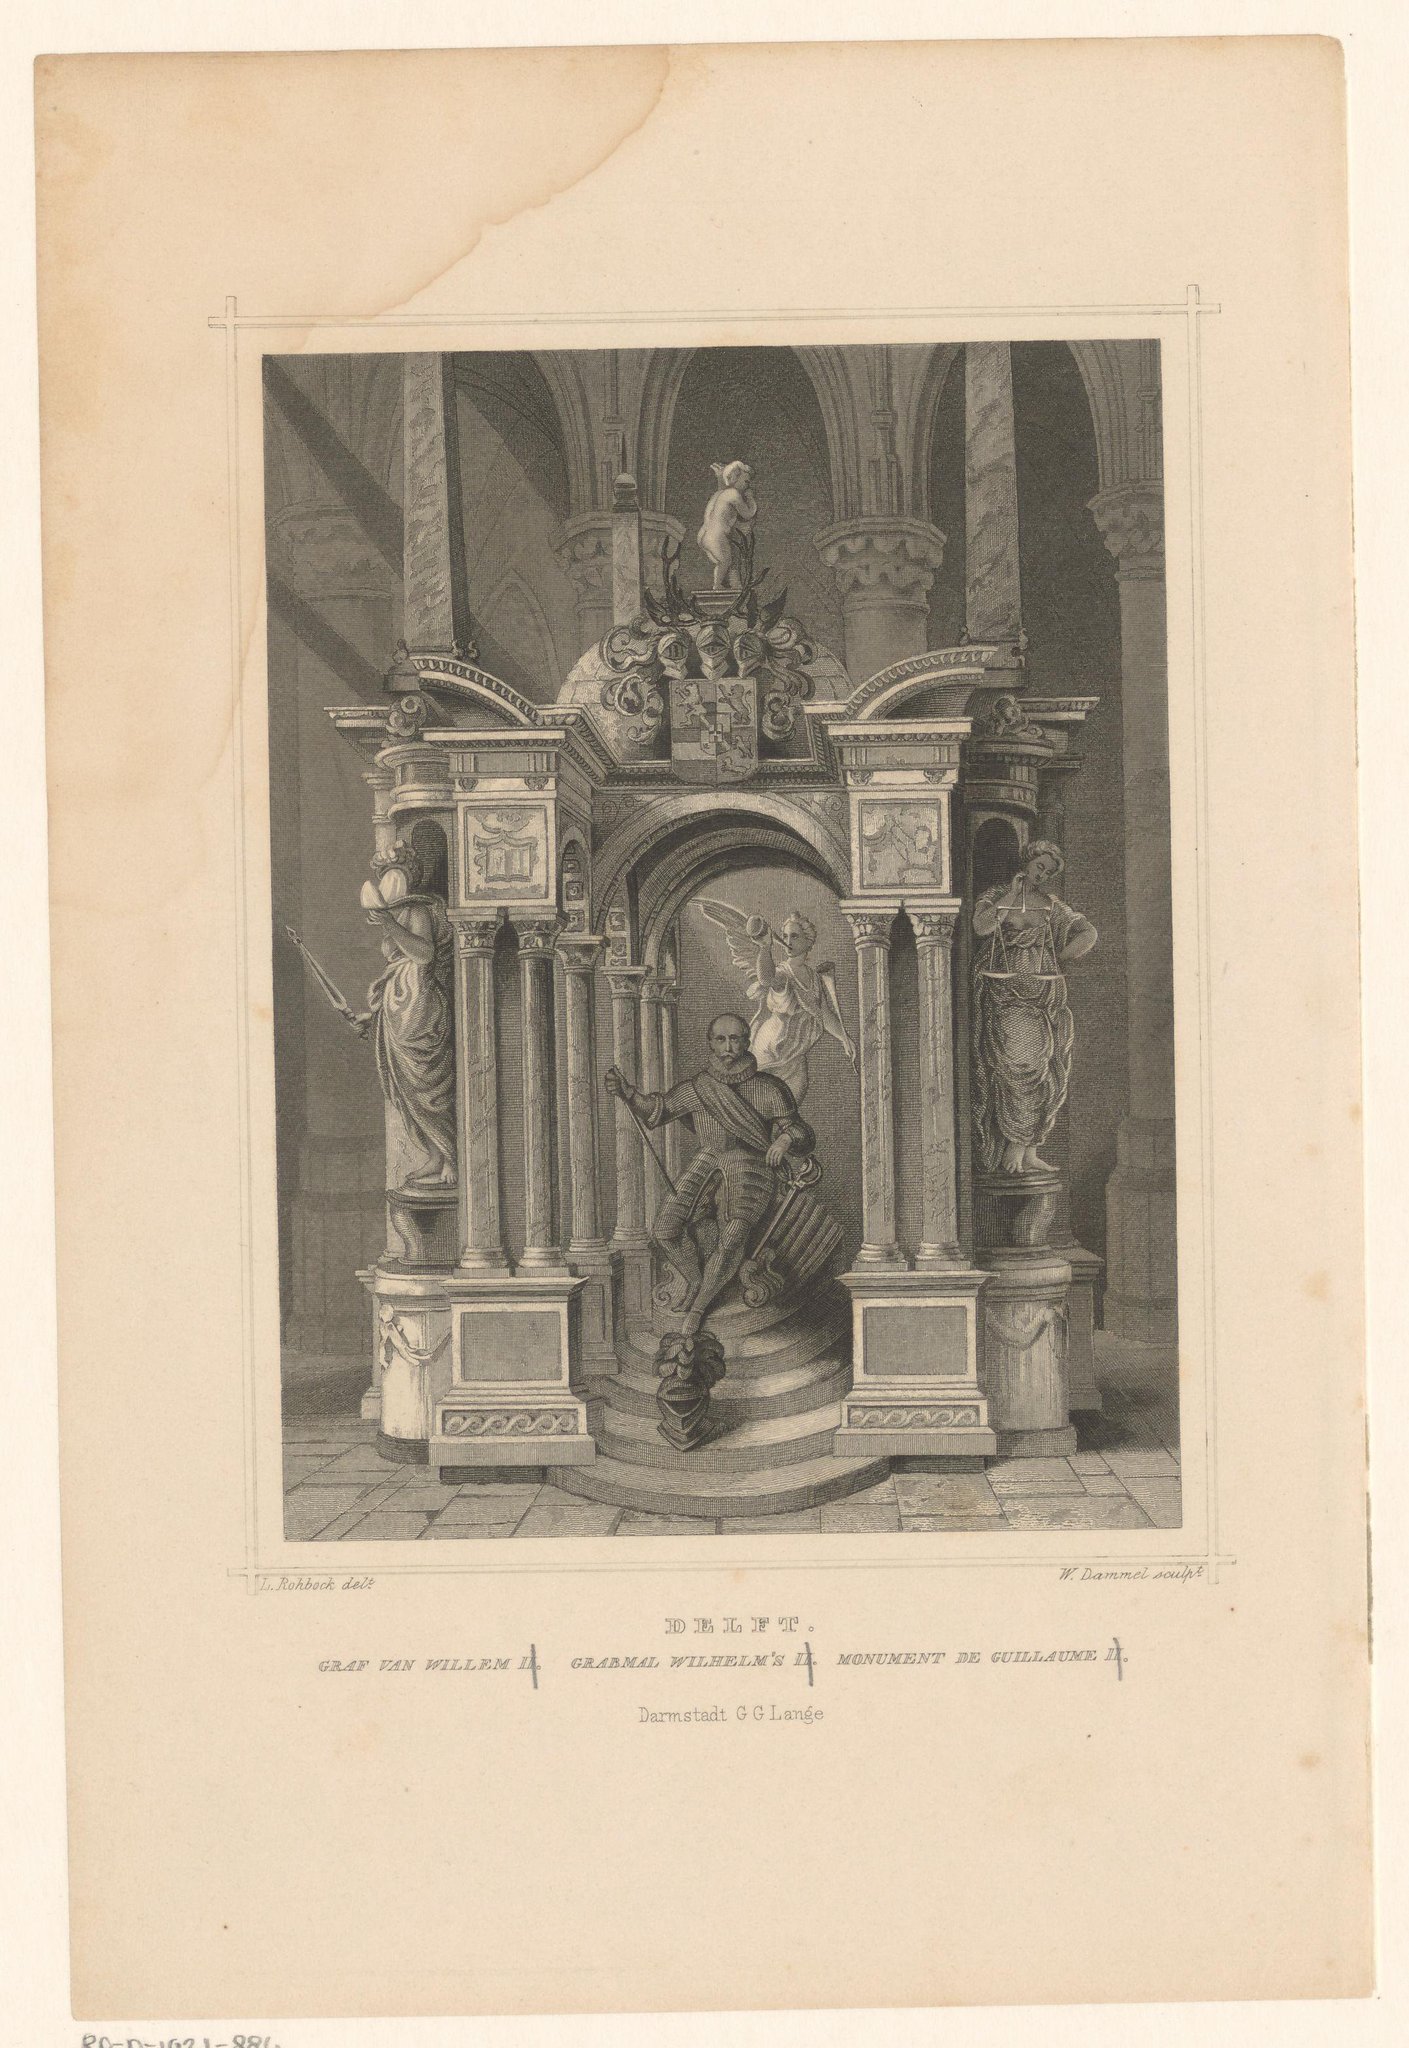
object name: print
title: Praalgraf van Willem van Oranje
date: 1834-1843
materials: paper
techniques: engraving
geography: delft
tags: william i (prince of orange), helmet, freedom, liberty; 'libertà' (ripa) (+ personification), justitia (justice) as roman personification, grave-building, monumental tomb, armorial bearing, heraldry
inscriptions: collector's mark: Lugt 2233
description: In het onderschrift staat ten onrechte vermeld dat het gaat om het graf van Willem II.